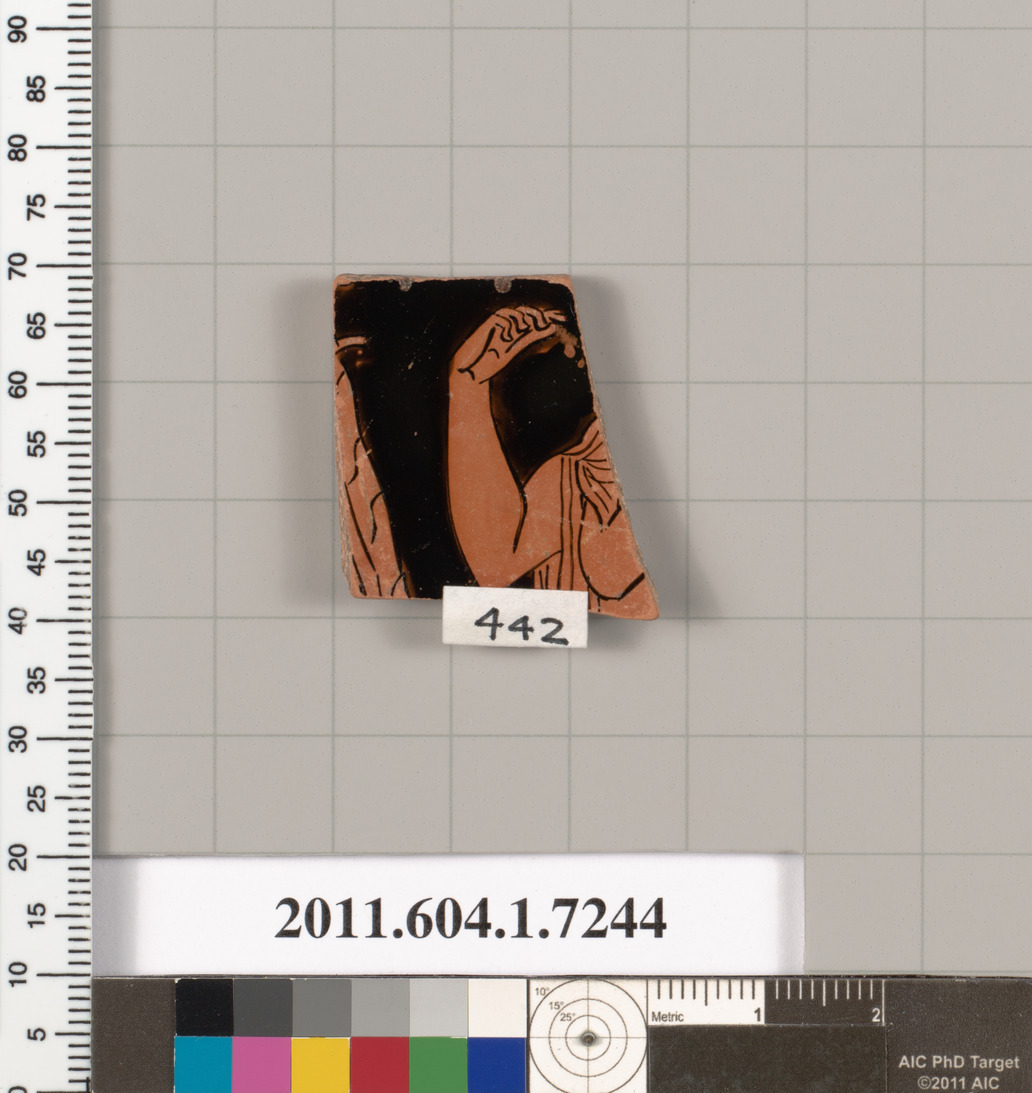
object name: kylix fragment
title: Terracotta fragment of a kylix (drinking cup)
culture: greek, attic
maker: makron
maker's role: artist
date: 500-480 BCE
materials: terracotta